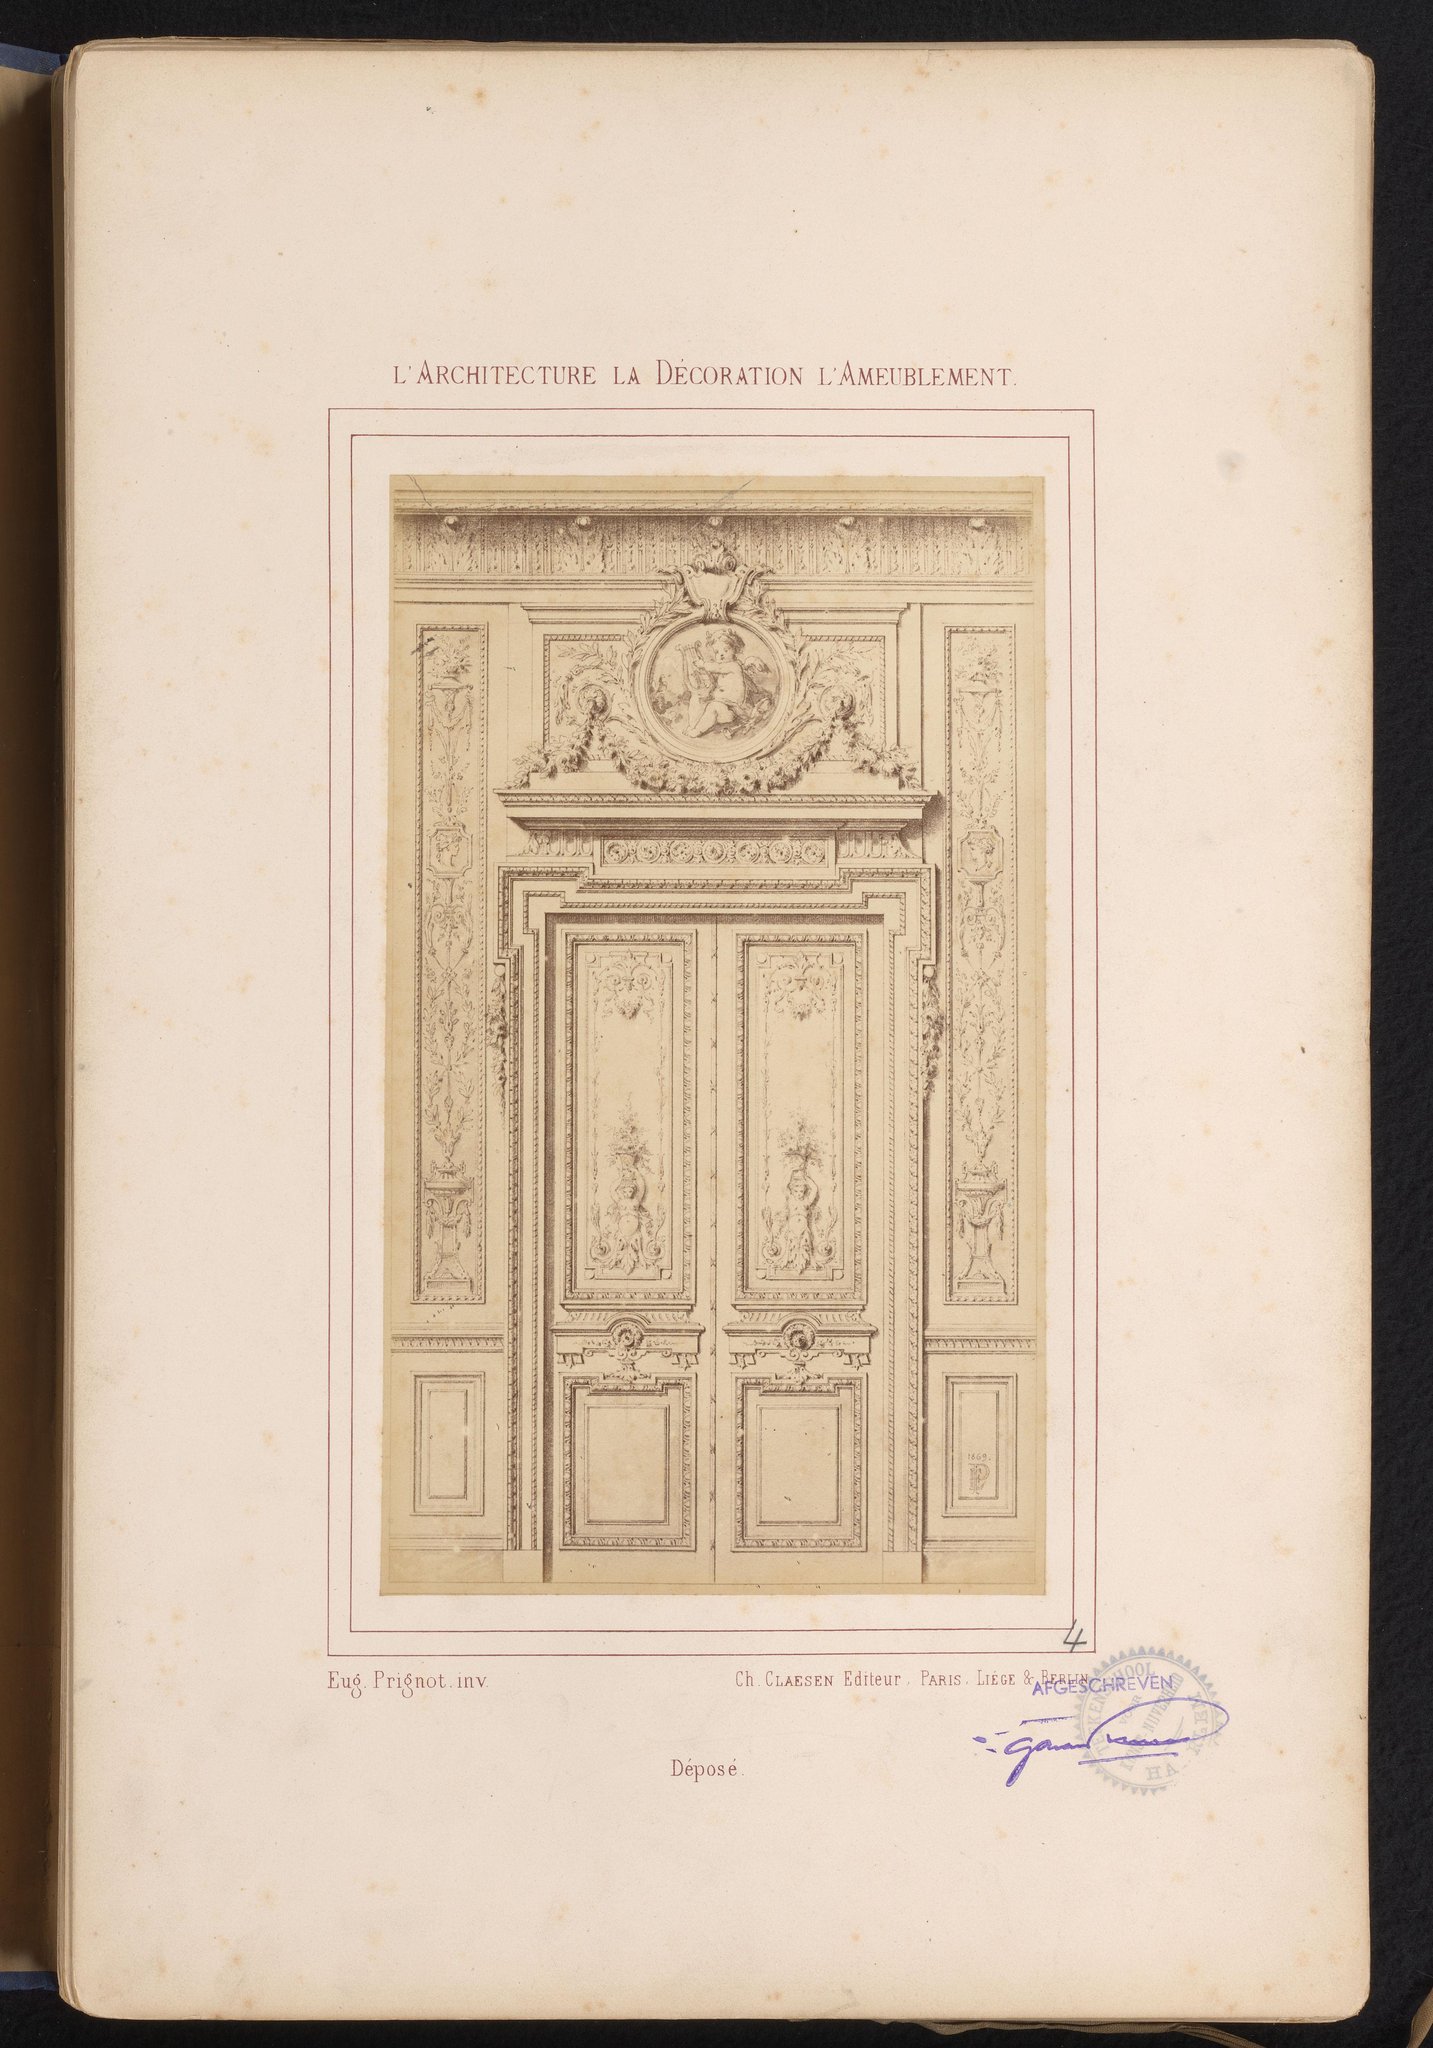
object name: reproduction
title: Fotoreproductie van een ontwerp voor een deur naar Alexandre Eugène Prignot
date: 1873-1880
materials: cardboard, paper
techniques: albumen print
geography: liège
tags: door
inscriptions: inscription: ‘Déposé’, number: ‘4’, stamp: ‘AFGESCHREVEN/ [...]’, inscription: ‘Eug. Prignot. inv.’, stamp: ‘TEEKENSCHOOL/ VOOR/ KUNSTNIJVERHEID/ HAARLEM’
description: Deze foto maakt deel uit van een omslag met 61 foto's op 61 bladen.